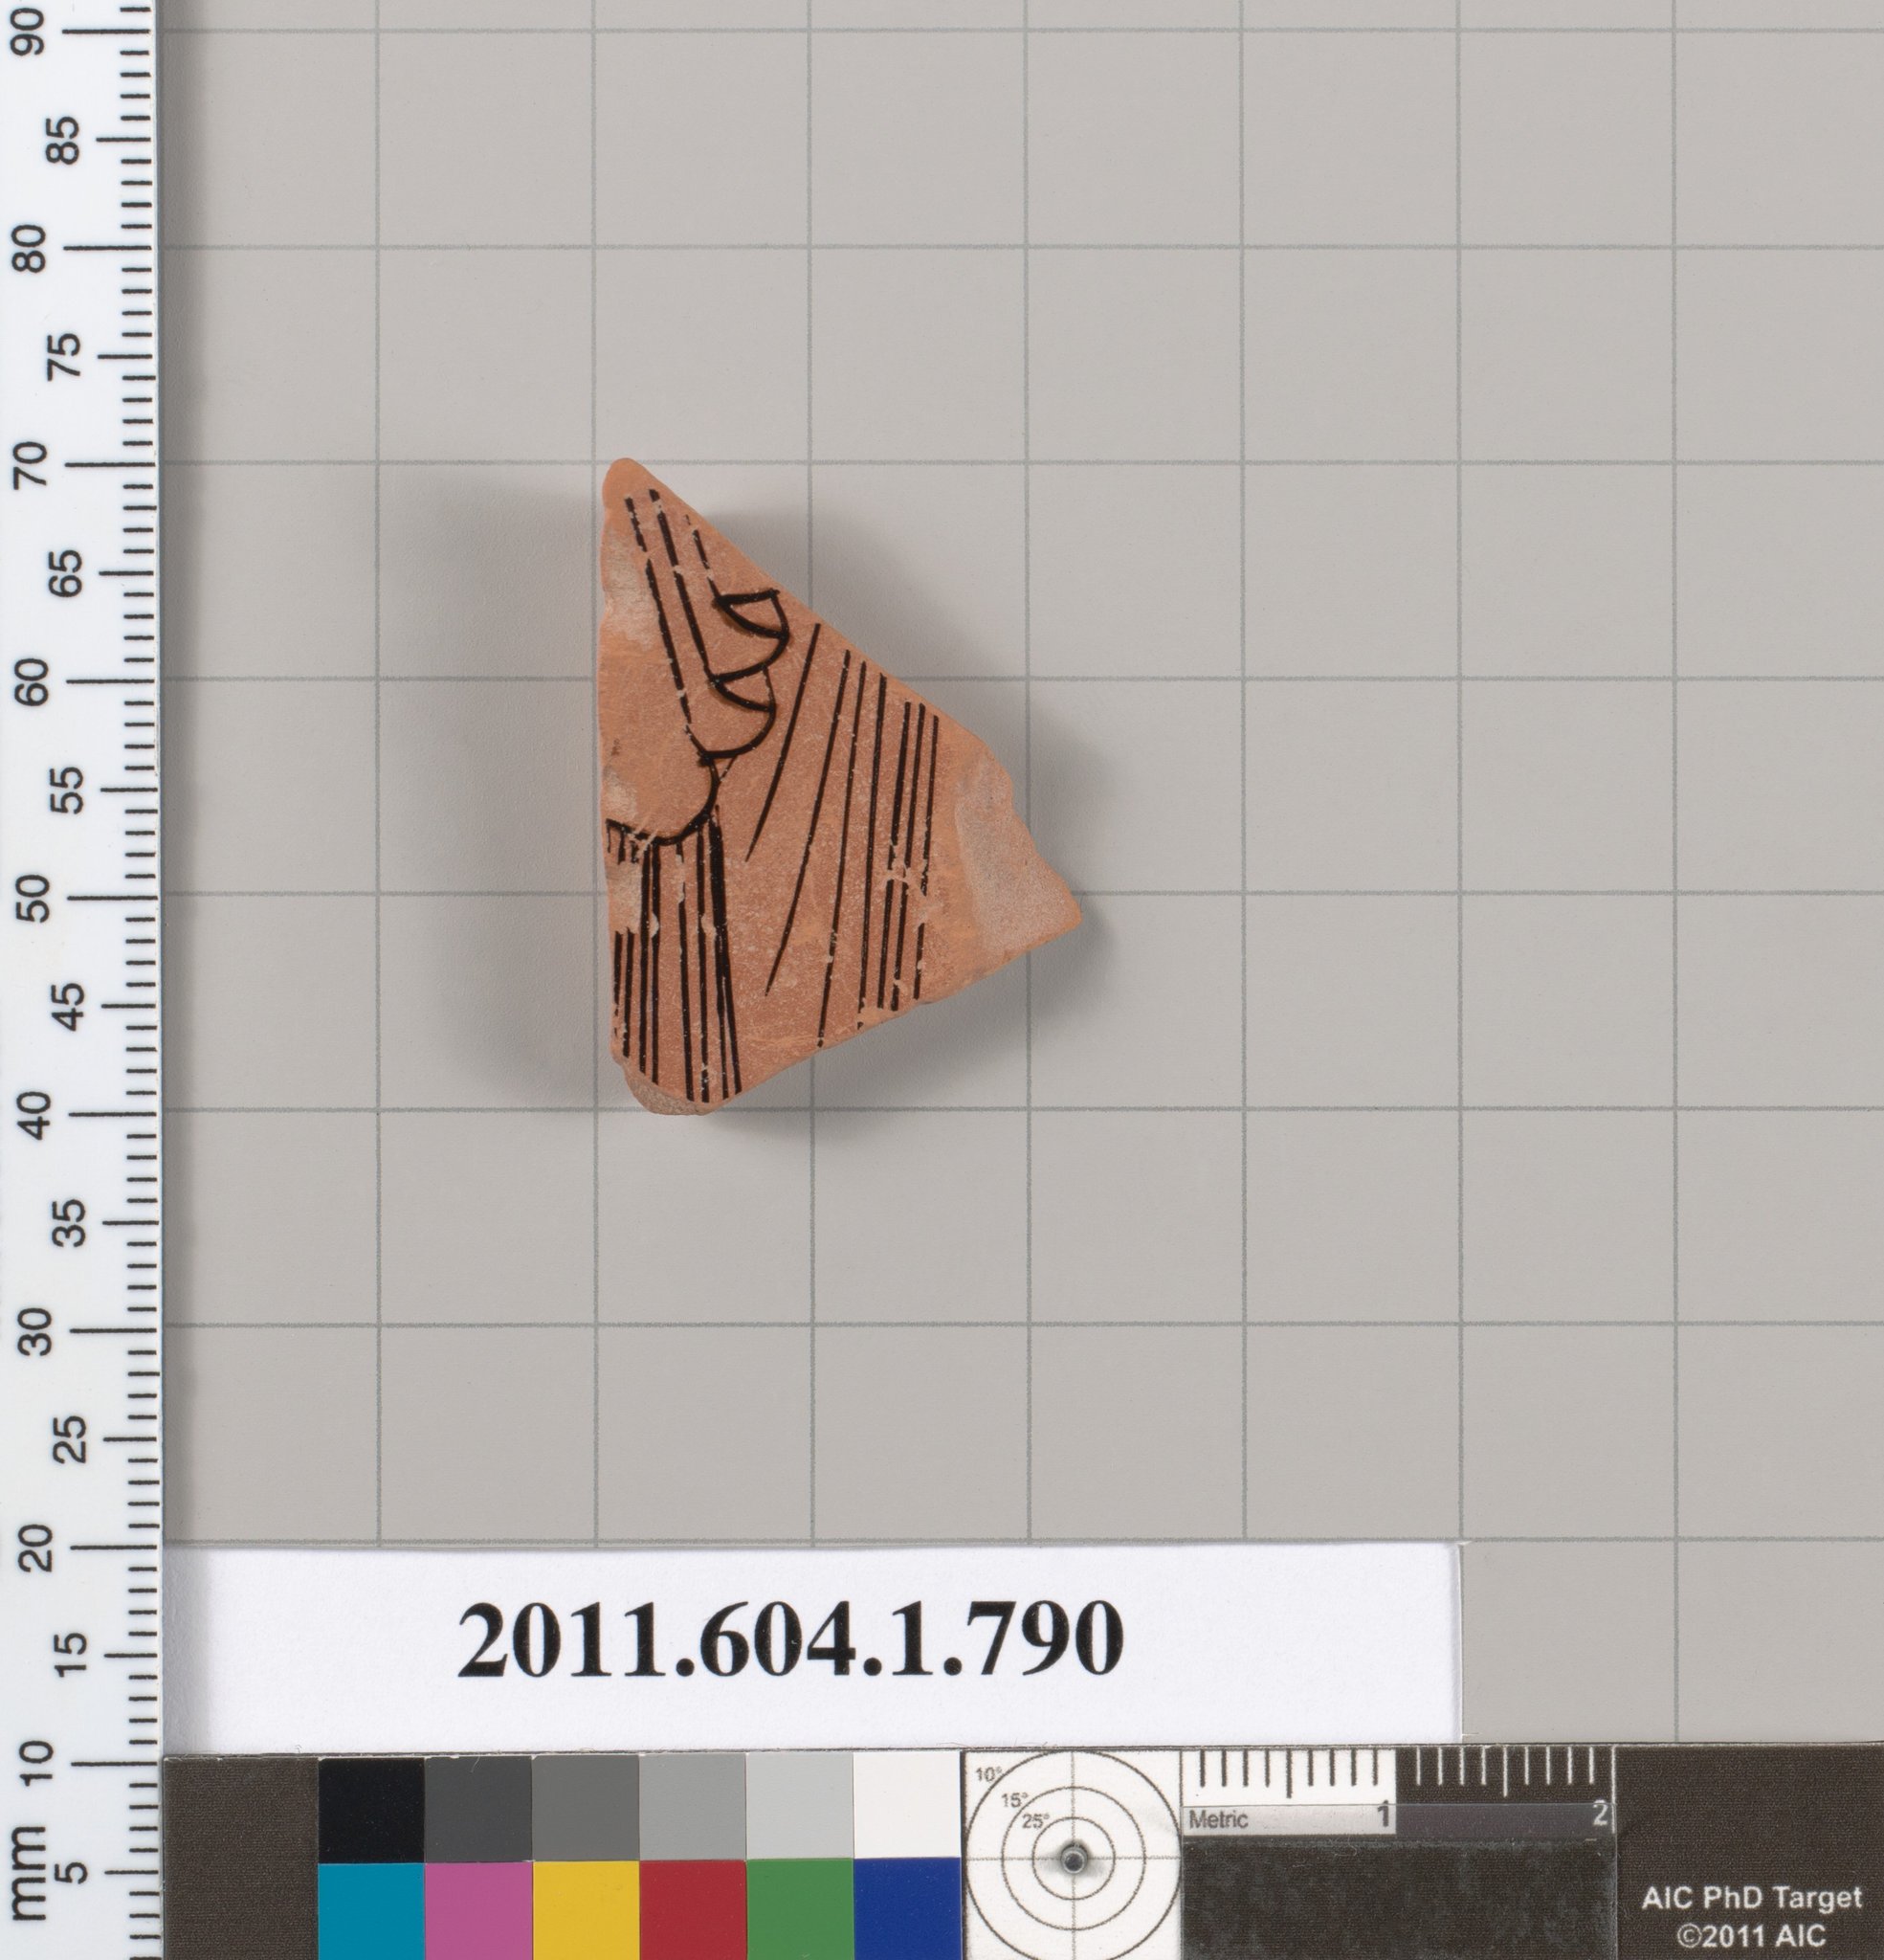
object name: kylix fragment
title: Terracotta fragment of a kylix (drinking cup)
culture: greek, attic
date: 490-480 BCE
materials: terracotta